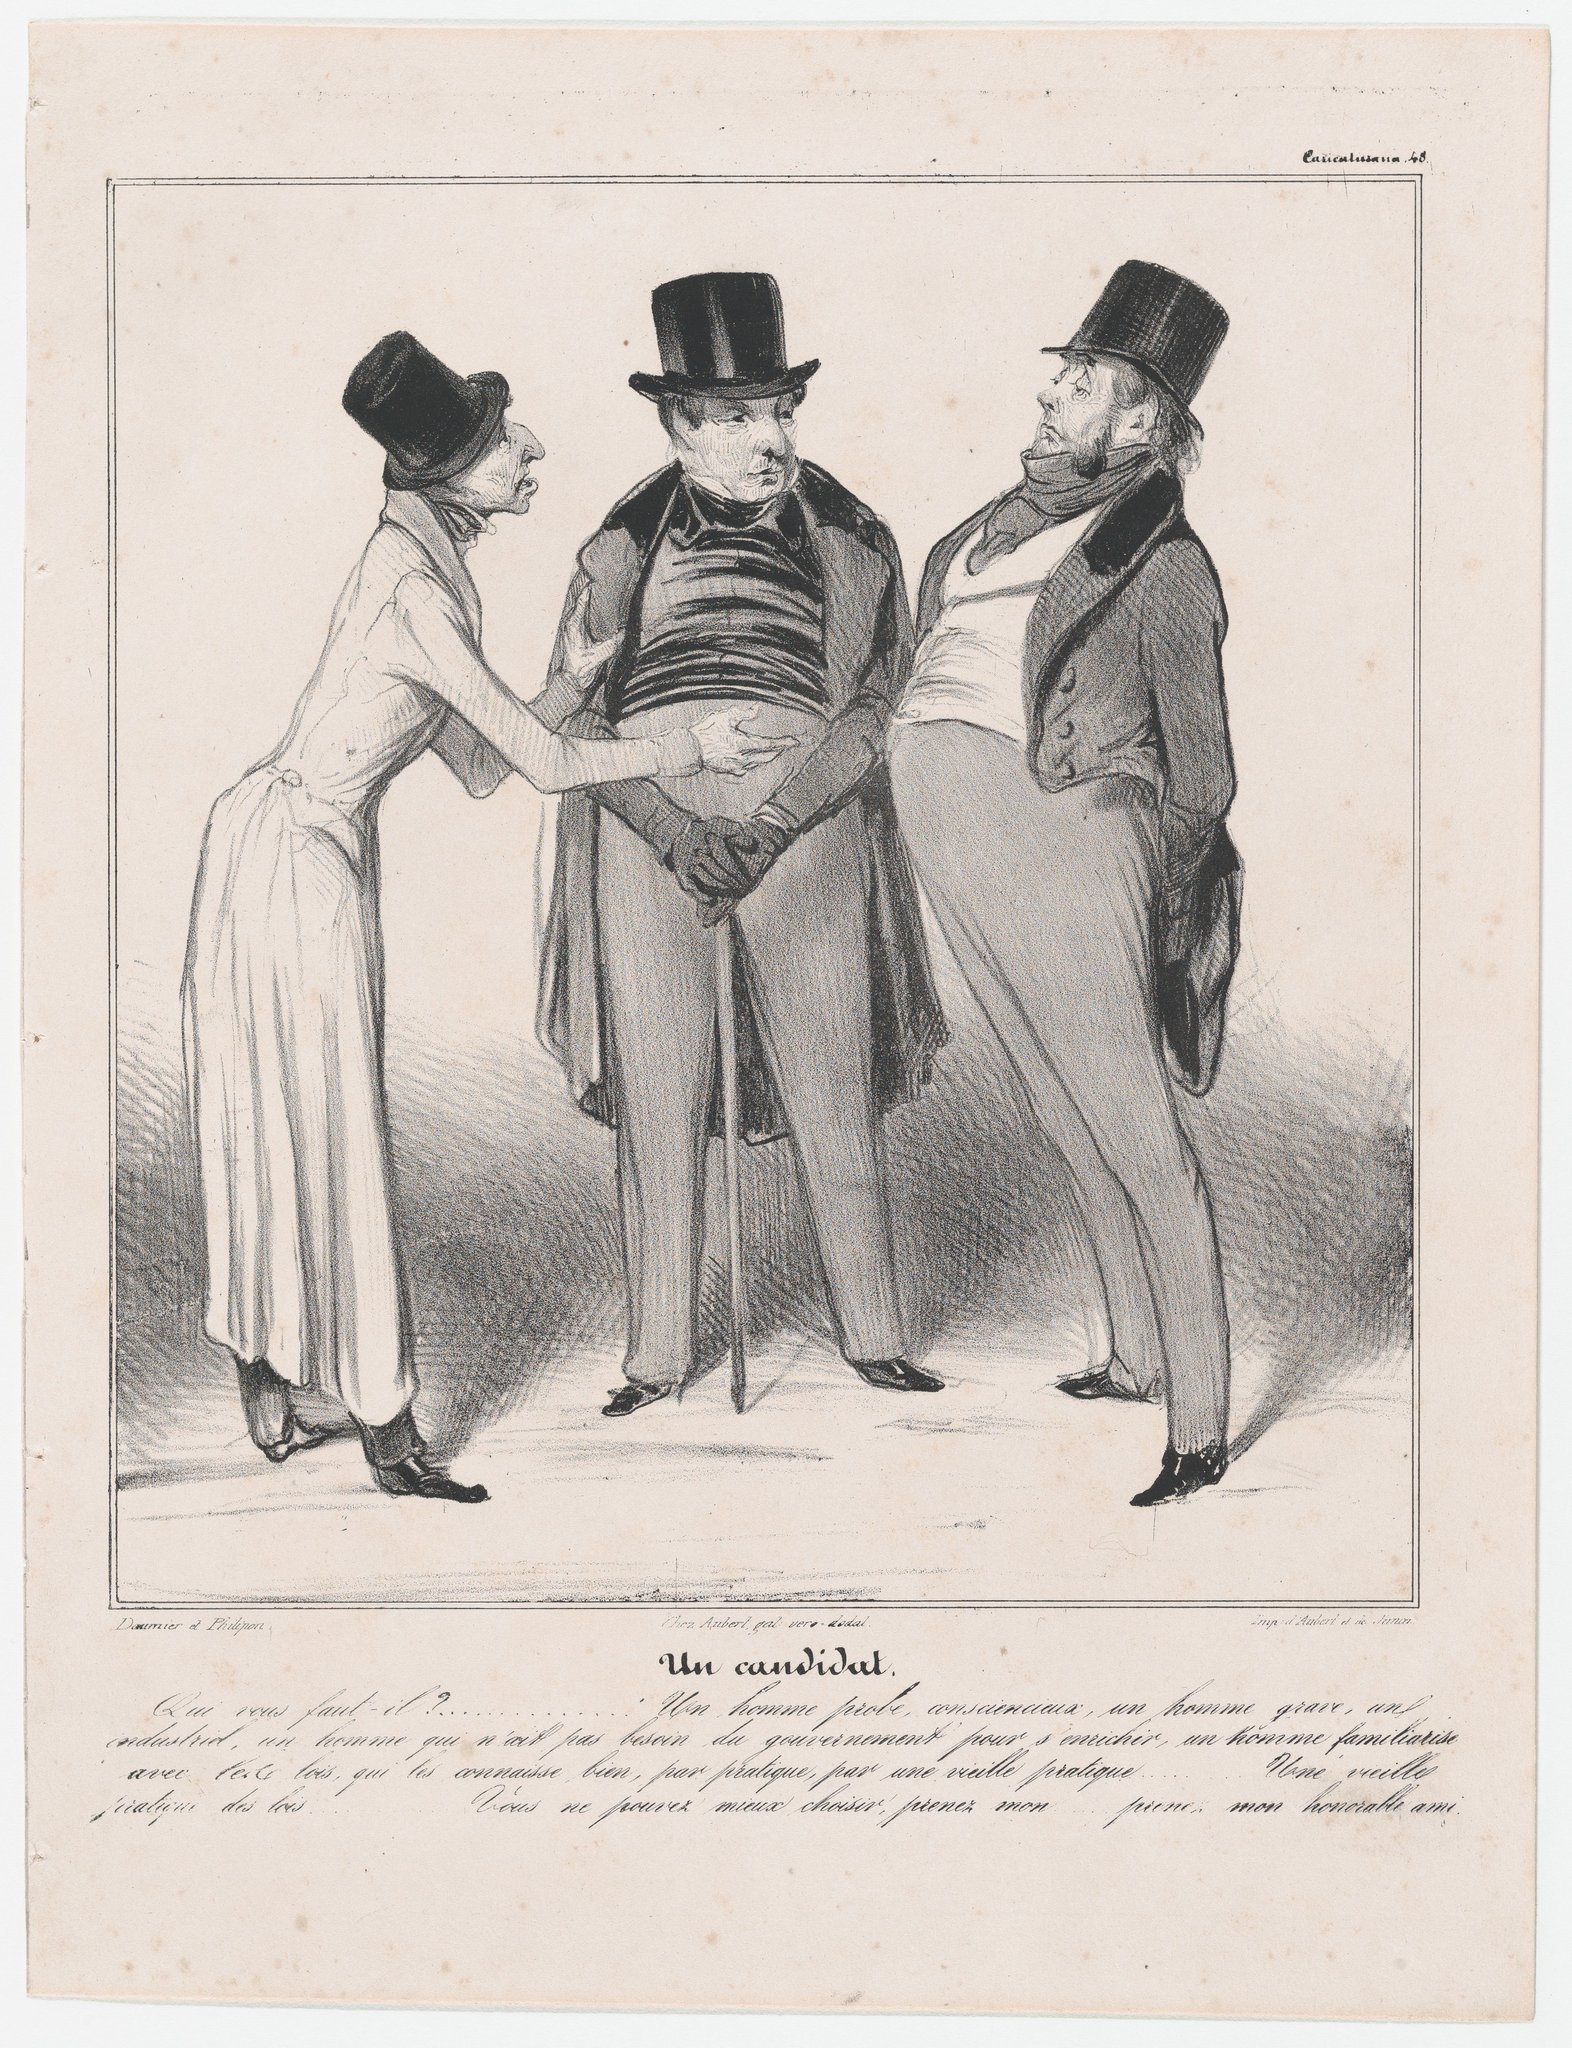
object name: print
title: Plate 48: A Candidate, from 'Caricaturana,' published in Les Robert Macaires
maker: honoré daumier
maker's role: artist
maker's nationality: french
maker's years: 1808-1879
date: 1838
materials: paper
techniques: lithograph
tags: men,women